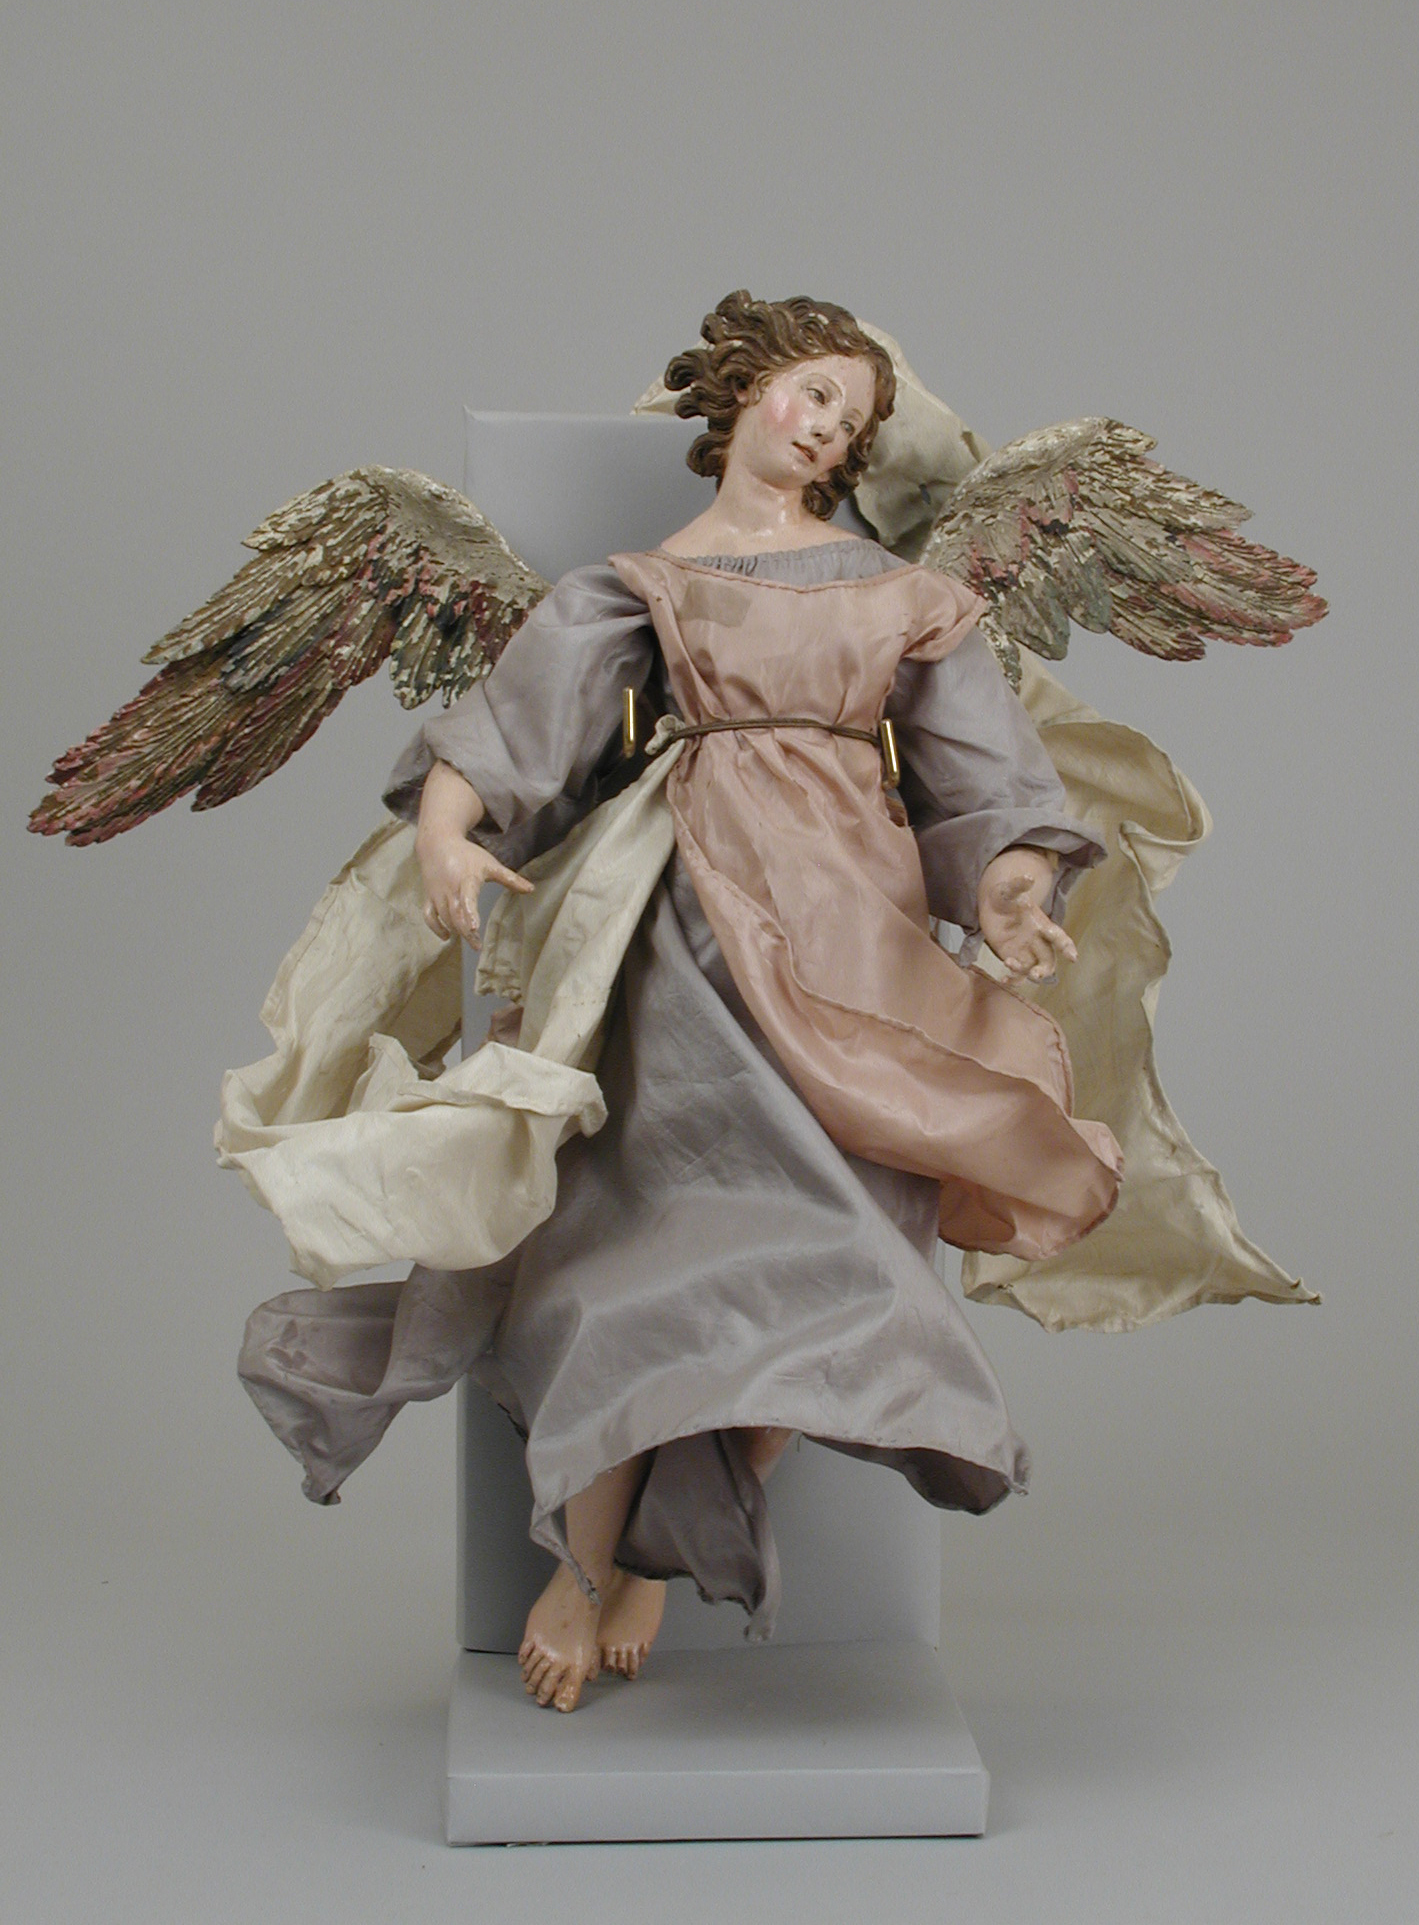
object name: crèche figure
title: Angel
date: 1751-1800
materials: terracotta, fiber, metal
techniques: polychrome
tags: angels